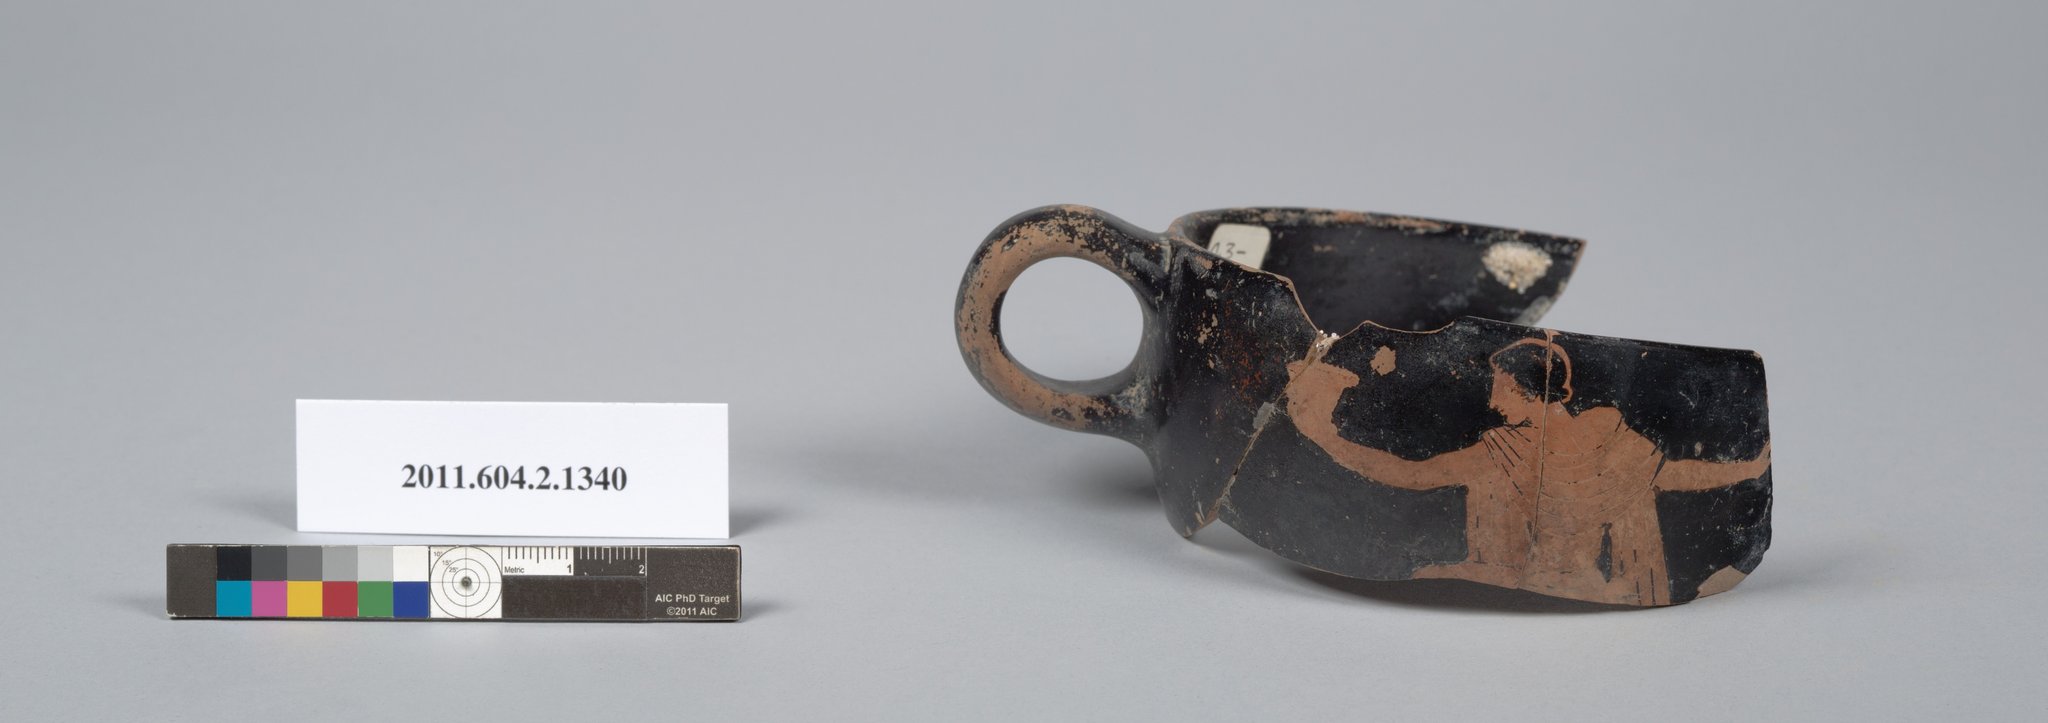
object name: skyphos fragment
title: Terracotta fragment of a skyphos (deep drinking cup)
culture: greek, attic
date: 460-450 BCE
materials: terracotta